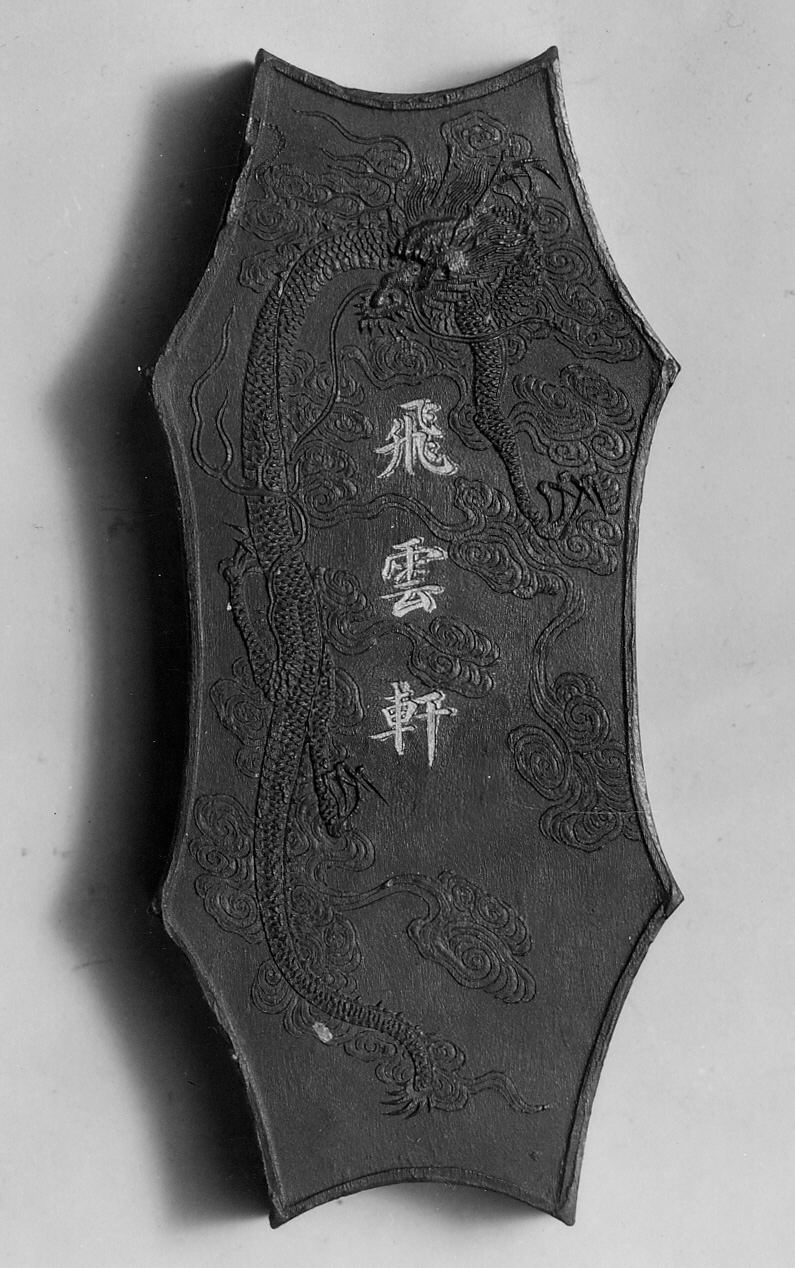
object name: ink tablet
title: Flying Clouds Pavilion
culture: chinese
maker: jian guzhai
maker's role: artist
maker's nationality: chinese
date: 1867-1933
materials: gilt, wood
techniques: bookbinding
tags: dragons